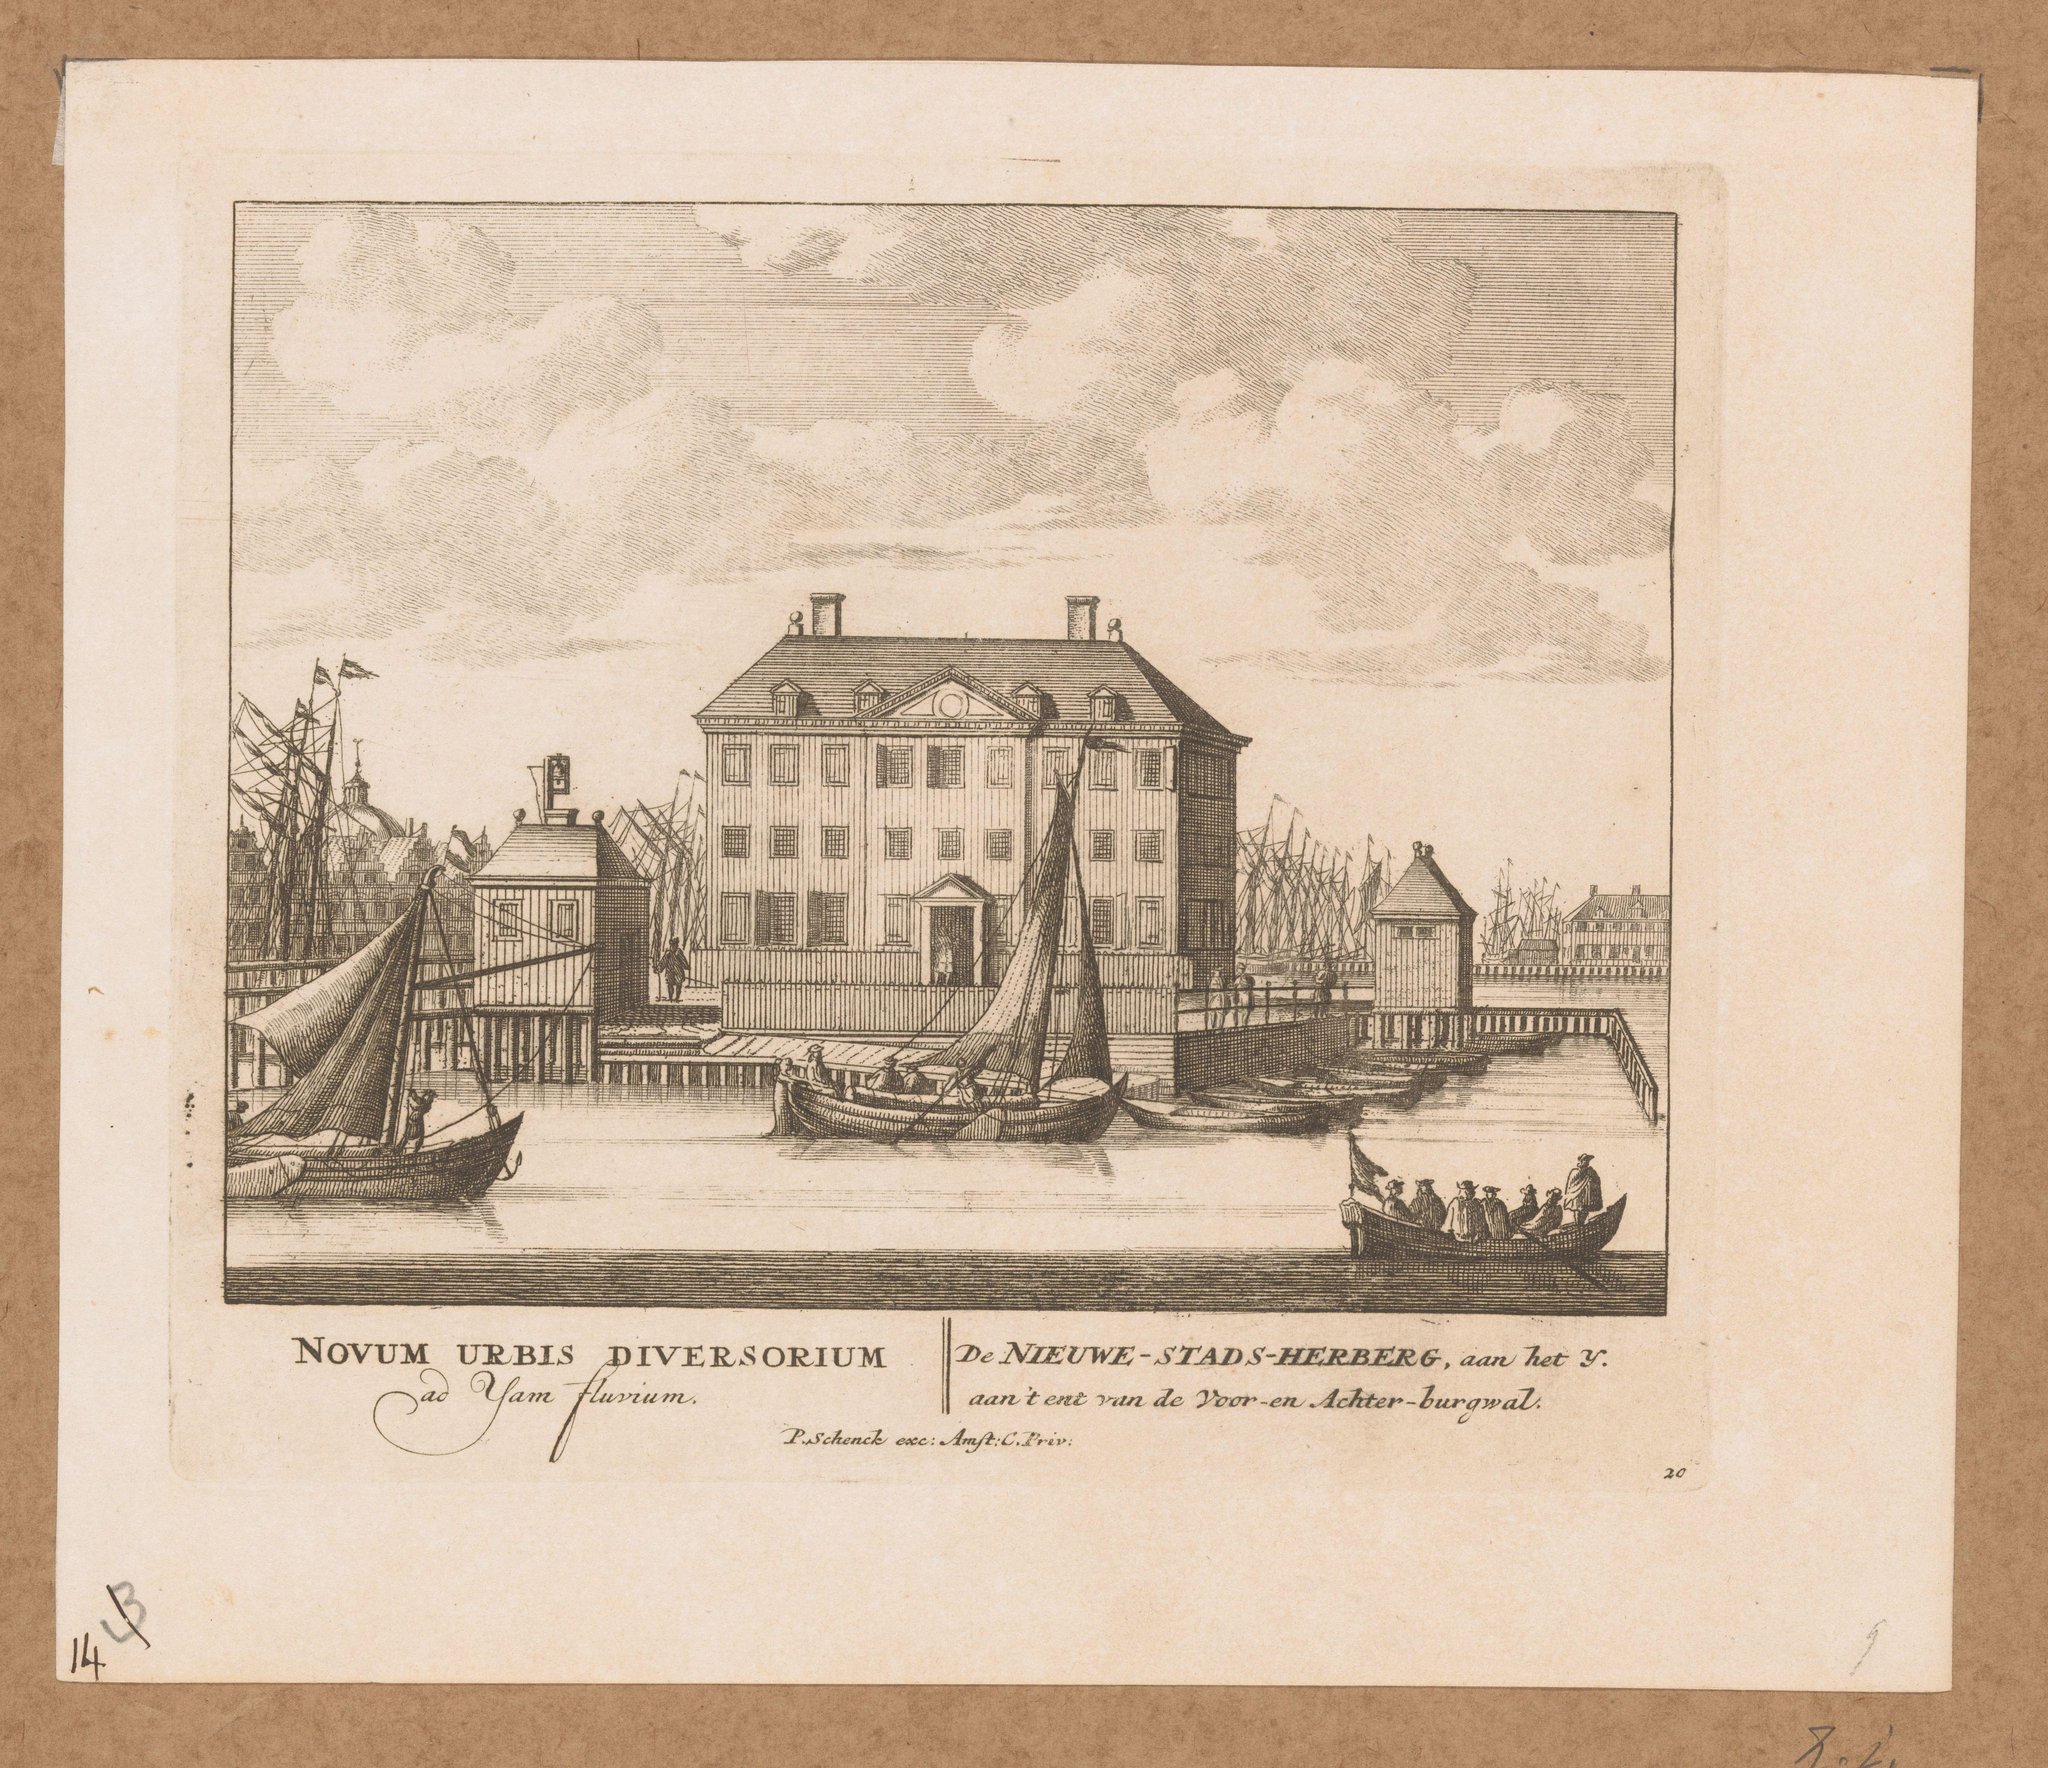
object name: print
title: Gezicht op de Nieuwe Stadsherberg aan het IJ in Amsterdam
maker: Anonymous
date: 1710-1711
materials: paper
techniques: engraving, etching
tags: sailing-ship, sailing-boat, rowing-boat, canoe, etc., bridge in city across river, canal, etc., hotel, hostelry, inn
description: Prent uit: 100 Afbeeldinge der voornaamste gebouwen van Amsterdam. Amsterdam: Pieter Schenk (I), [1710-1711]. Of: 100 Afbeeldinge der voornaamste gebouwen van Amsterdam. Amsterdam: Barent Greve, [1757-1766], prent nummer 20. In de tweede uitgave, uitgegeven door Barent Greve, is alleen de titelprent aangepast. De overige prenten zijn onveranderd gebleven.